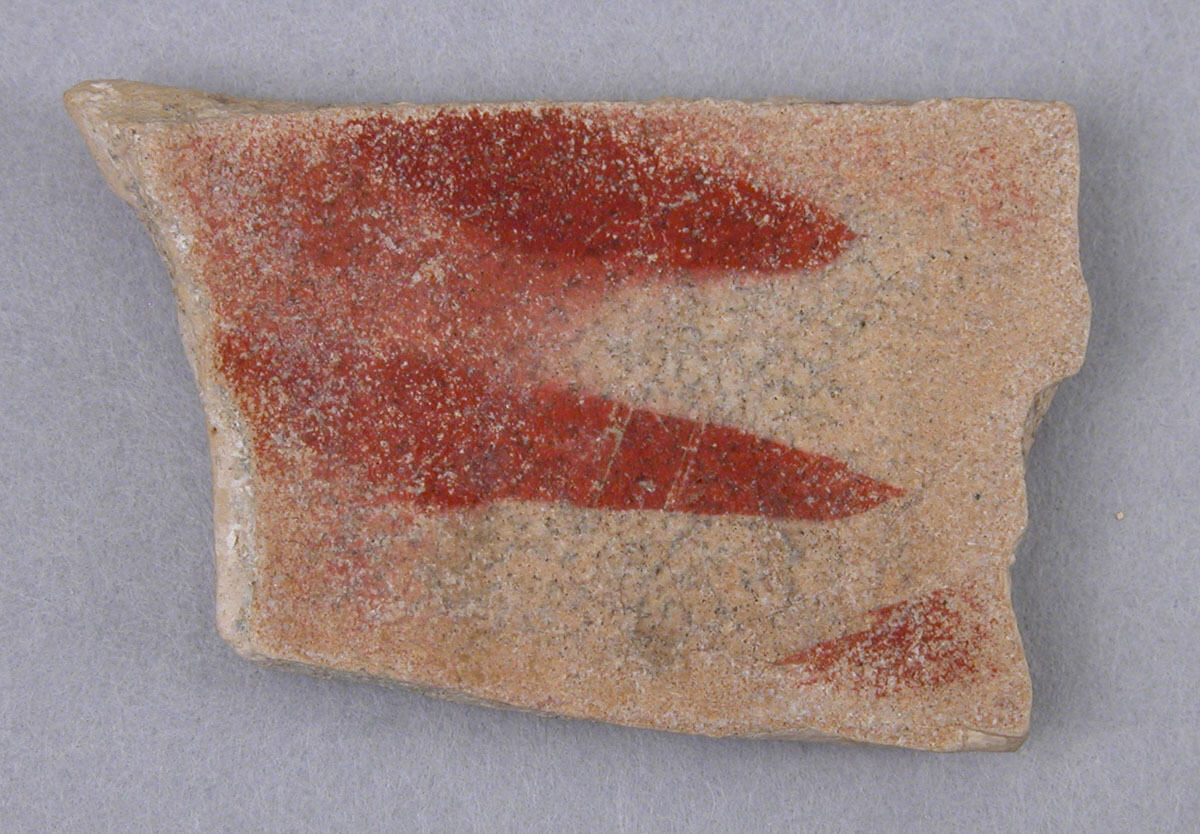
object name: fragment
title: Ceramic Fragment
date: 801-900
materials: earthenware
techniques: glazing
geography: saudi arabia